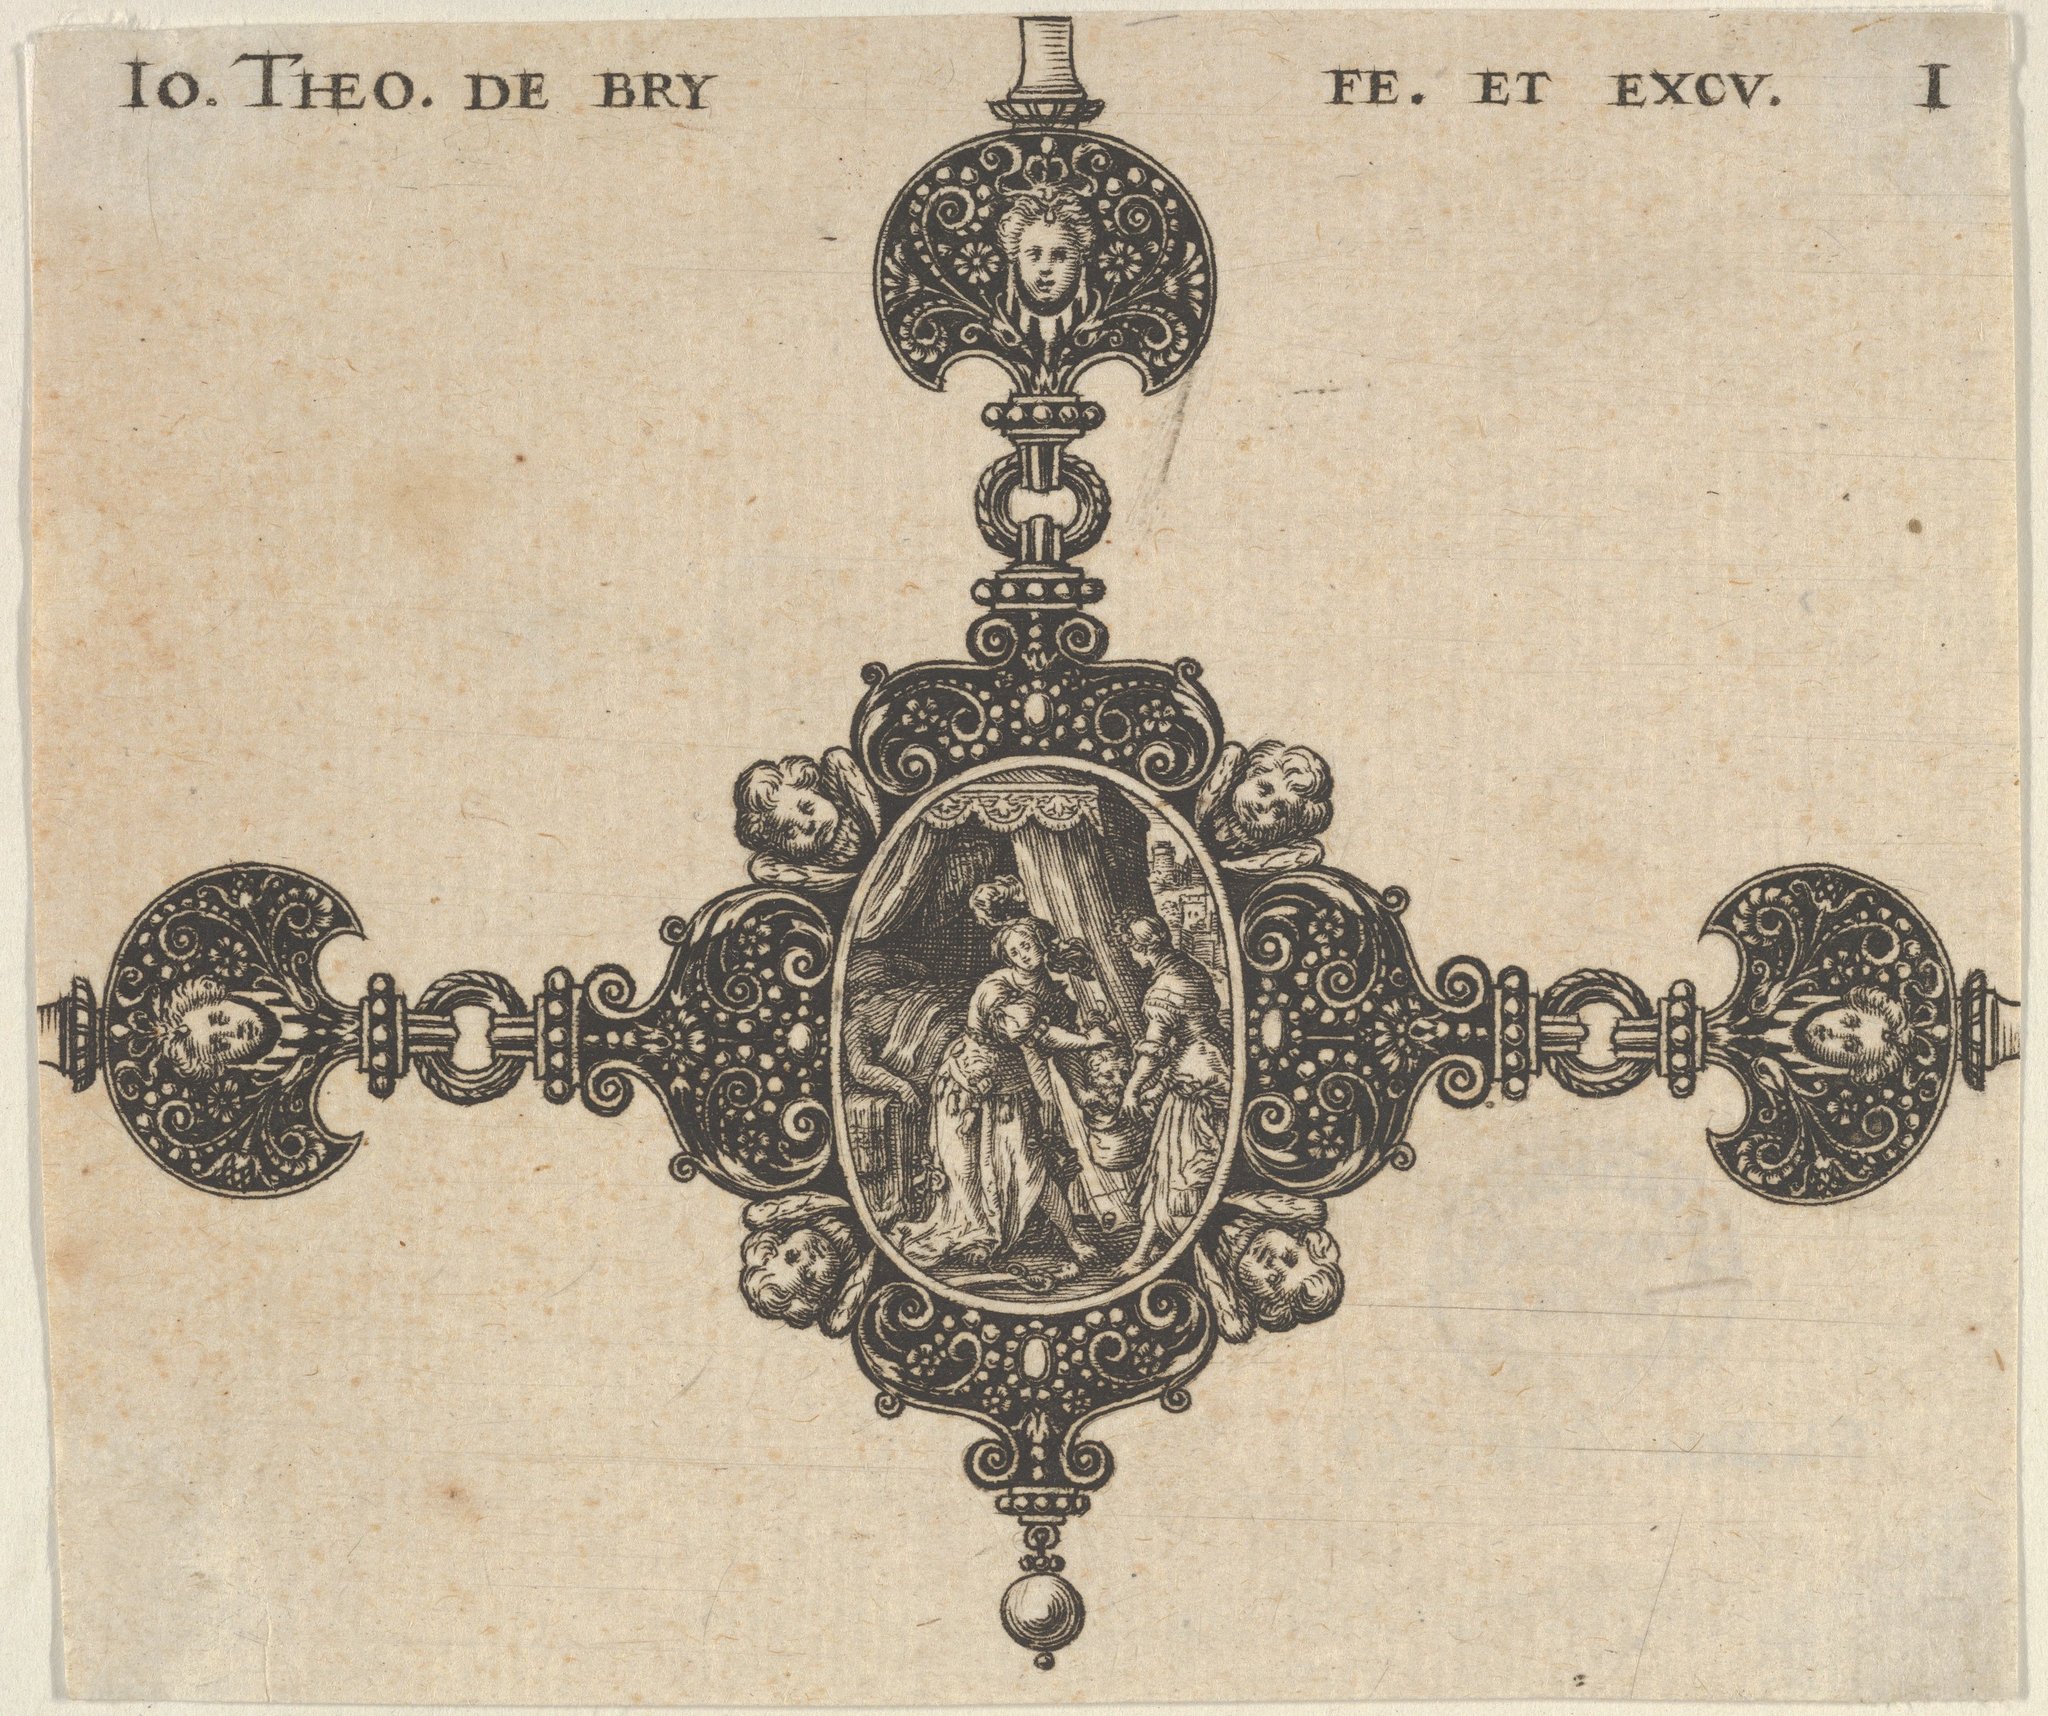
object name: print ornament architecture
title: Design for a Brooch with Judith Holding the Head of Holofernes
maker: johann theodor de bry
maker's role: artist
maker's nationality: netherlandish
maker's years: 1561-1623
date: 1580-1600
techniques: embroidery, engraving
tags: jewelry,brooches,judith